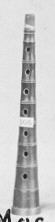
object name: suona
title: Suona (嗩吶 ) body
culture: chinese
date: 1867-1900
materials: brass, wood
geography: china